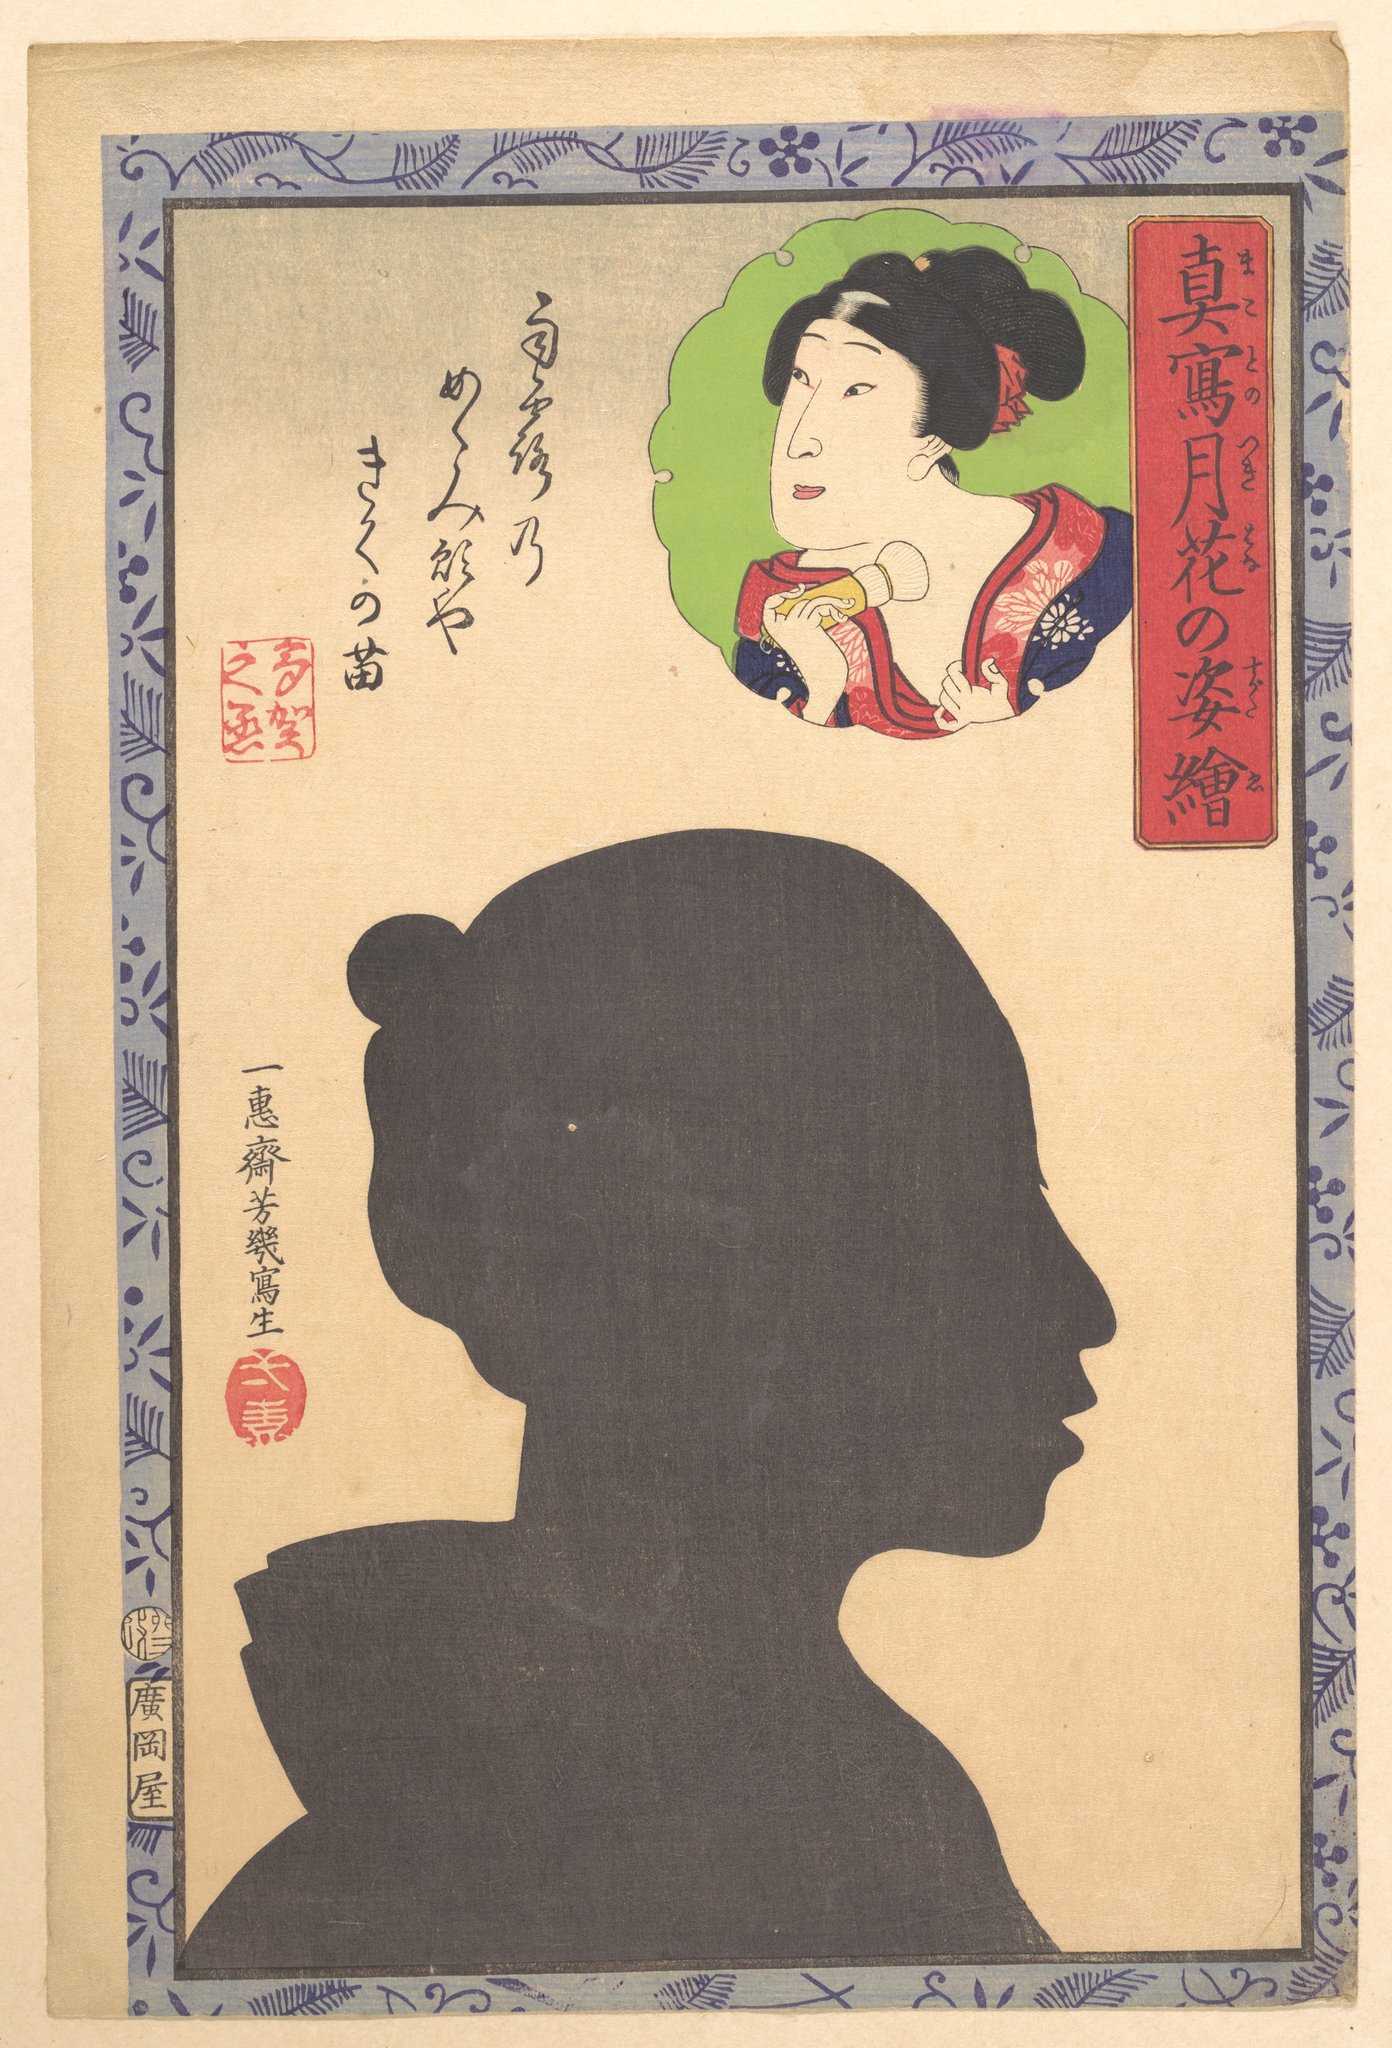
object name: print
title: Silhouette Image of Kabuki Actor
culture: japanese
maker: utagawa yoshiiku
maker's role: artist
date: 1801-1900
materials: ink, paper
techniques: woodblock print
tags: profiles,women,actors